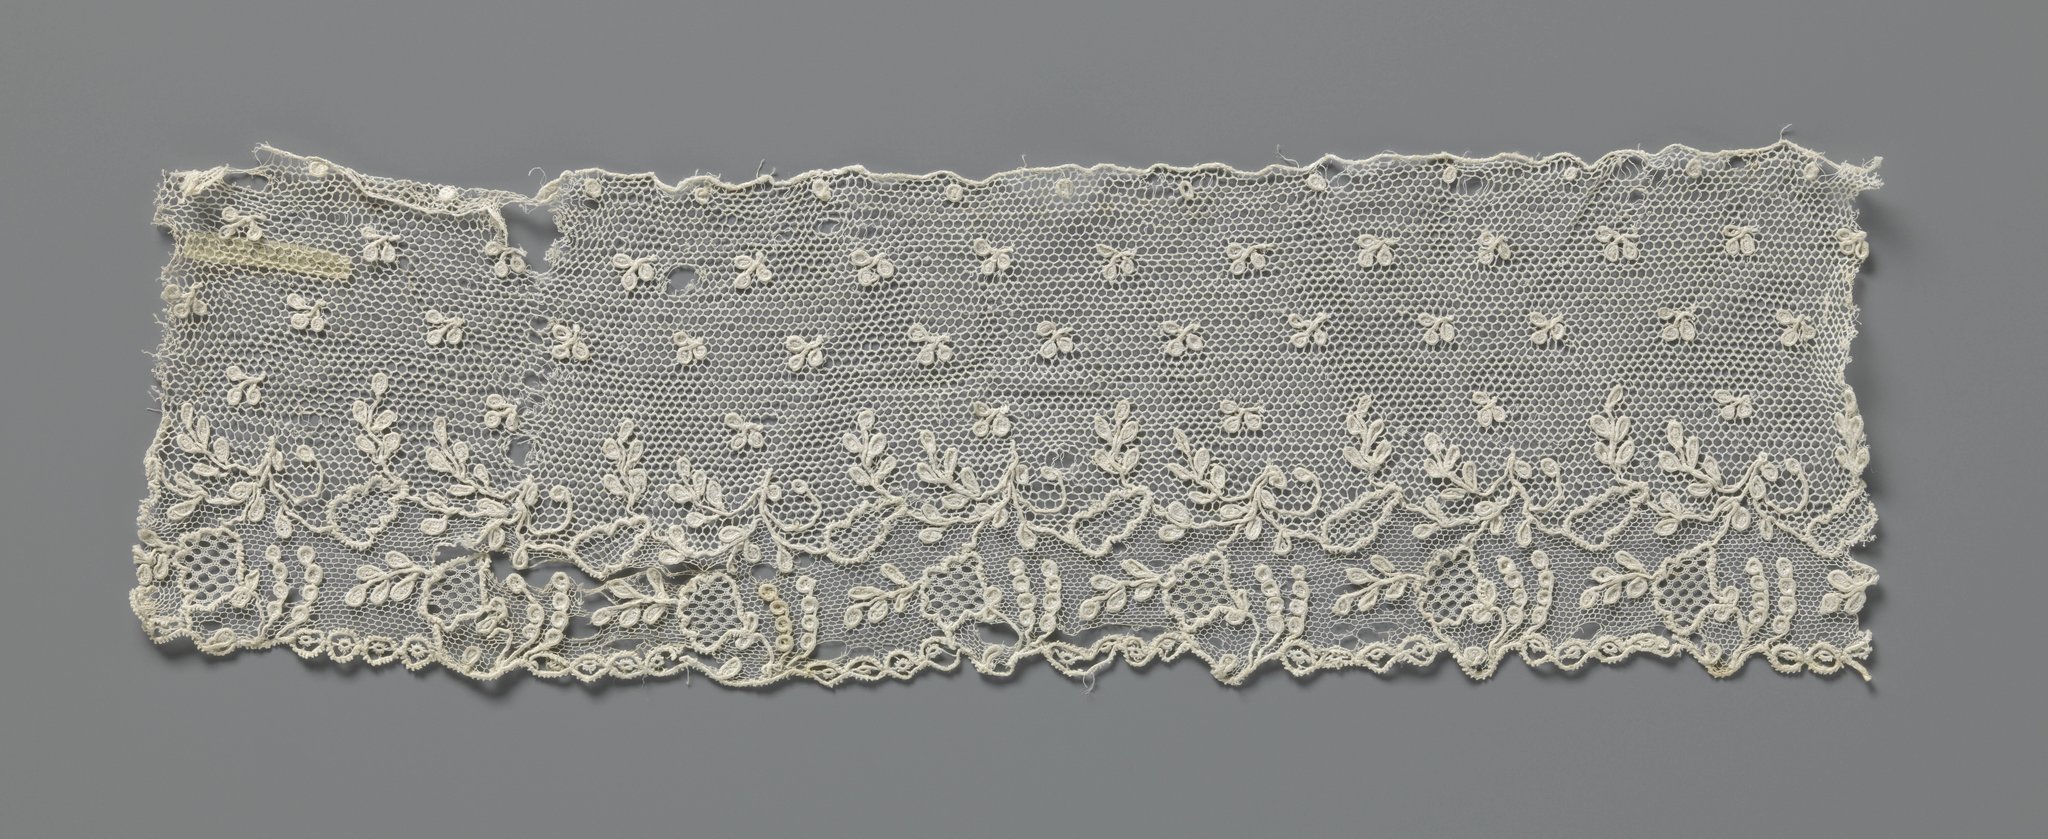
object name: strip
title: Strook naaldkant met klaverblaadjes en waaiervormige bloemen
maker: Anonymous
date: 1775-1799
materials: linen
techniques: lace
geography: alençon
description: Strook naturelkleurige naaldkant: heren-Alençon. Strooimotief met klaverblaadjes op een fijne zeshoekige maasgrond. Langs de bovenrand een rij moesjes. Het patroon aan de onderzijde van de strook bestaat uit een aaneenschakeling van bladertakken met pluimen. Daaronder waaiervormige bloemen die vanuit de onderrand ontspringen, gevuld met een siergrond. De onderzijde is afgewerkt met geschulpte rand van gepicoteerde cirkeltjes met daarin een raderpicot. De bovenzijde is afgewerkt met een rechte rand.